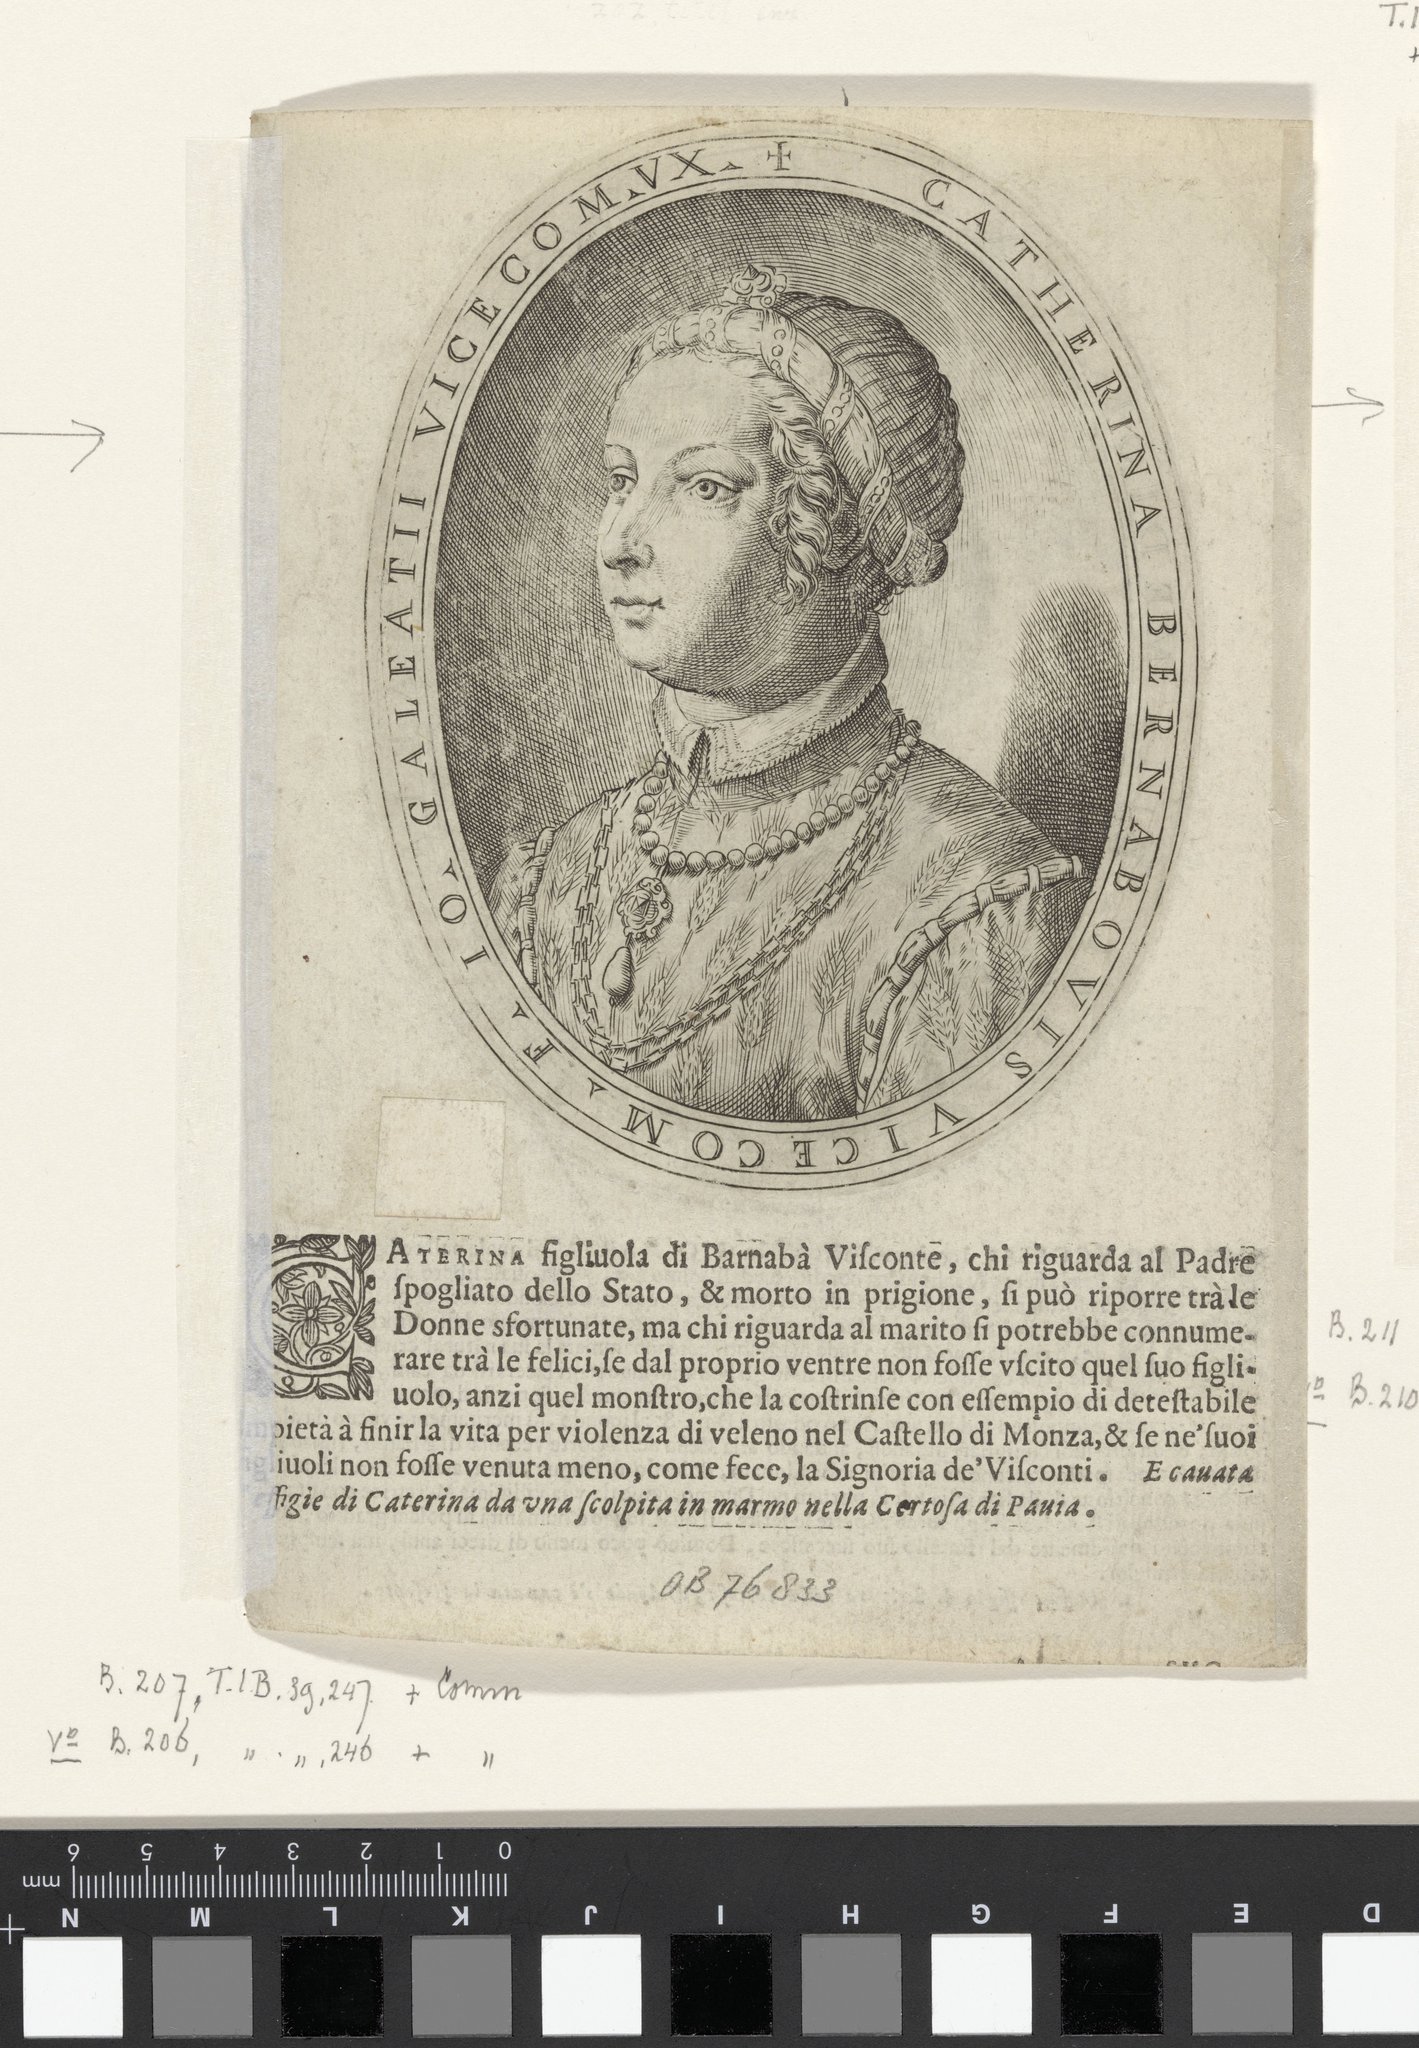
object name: book illustration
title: Portret van Catherina Visconti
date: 1585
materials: paper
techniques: engraving, letterpress printing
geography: italy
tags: historical persons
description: Prent uit Antonio Campo, Cremona fedelissima citta, et nobilissima colonia de Romani rappresentata in disegno col suo contado; et illustrata d'una breve historia, Milaan: Filippo Ghisolfi 1642, vol. 3, p. 91.